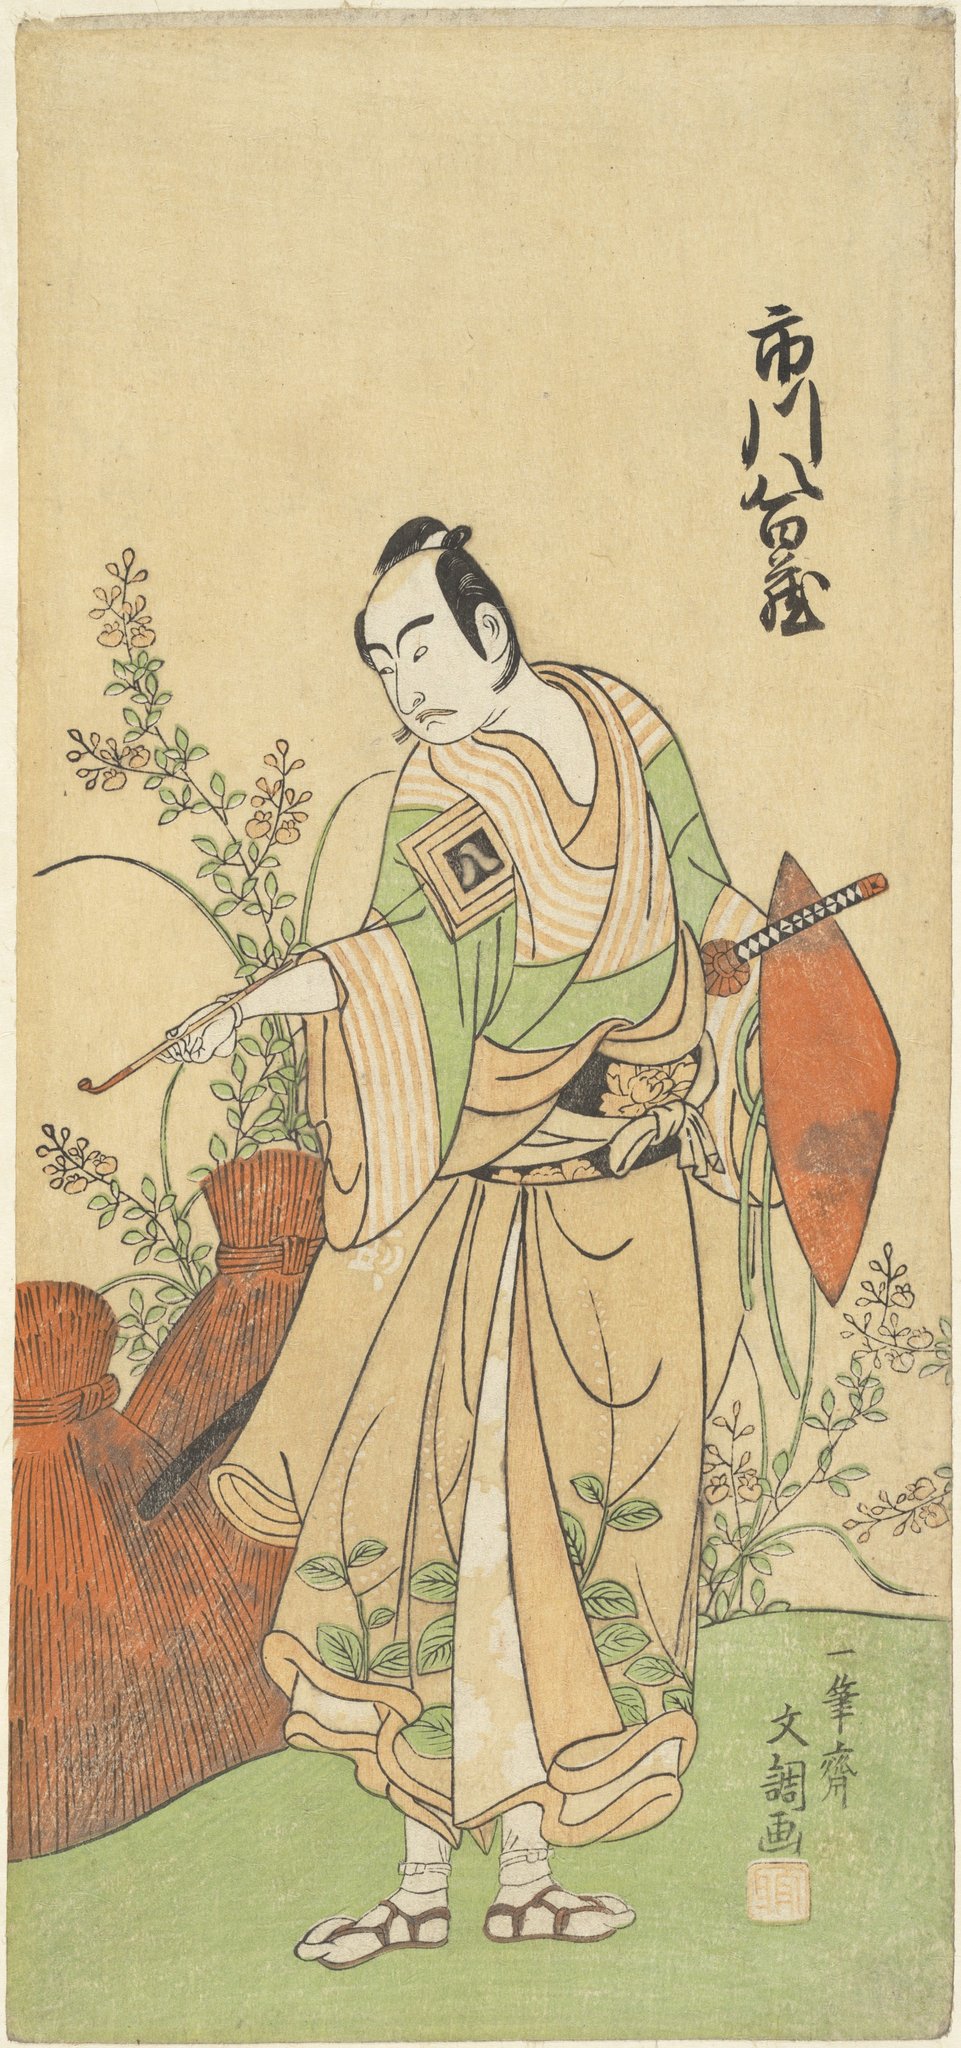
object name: print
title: Ichikawa Yaozō II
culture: japanese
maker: ippitsusai bunchō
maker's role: artist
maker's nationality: japanese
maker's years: 1765-1792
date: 1772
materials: ink, paper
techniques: woodblock print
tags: men,plants